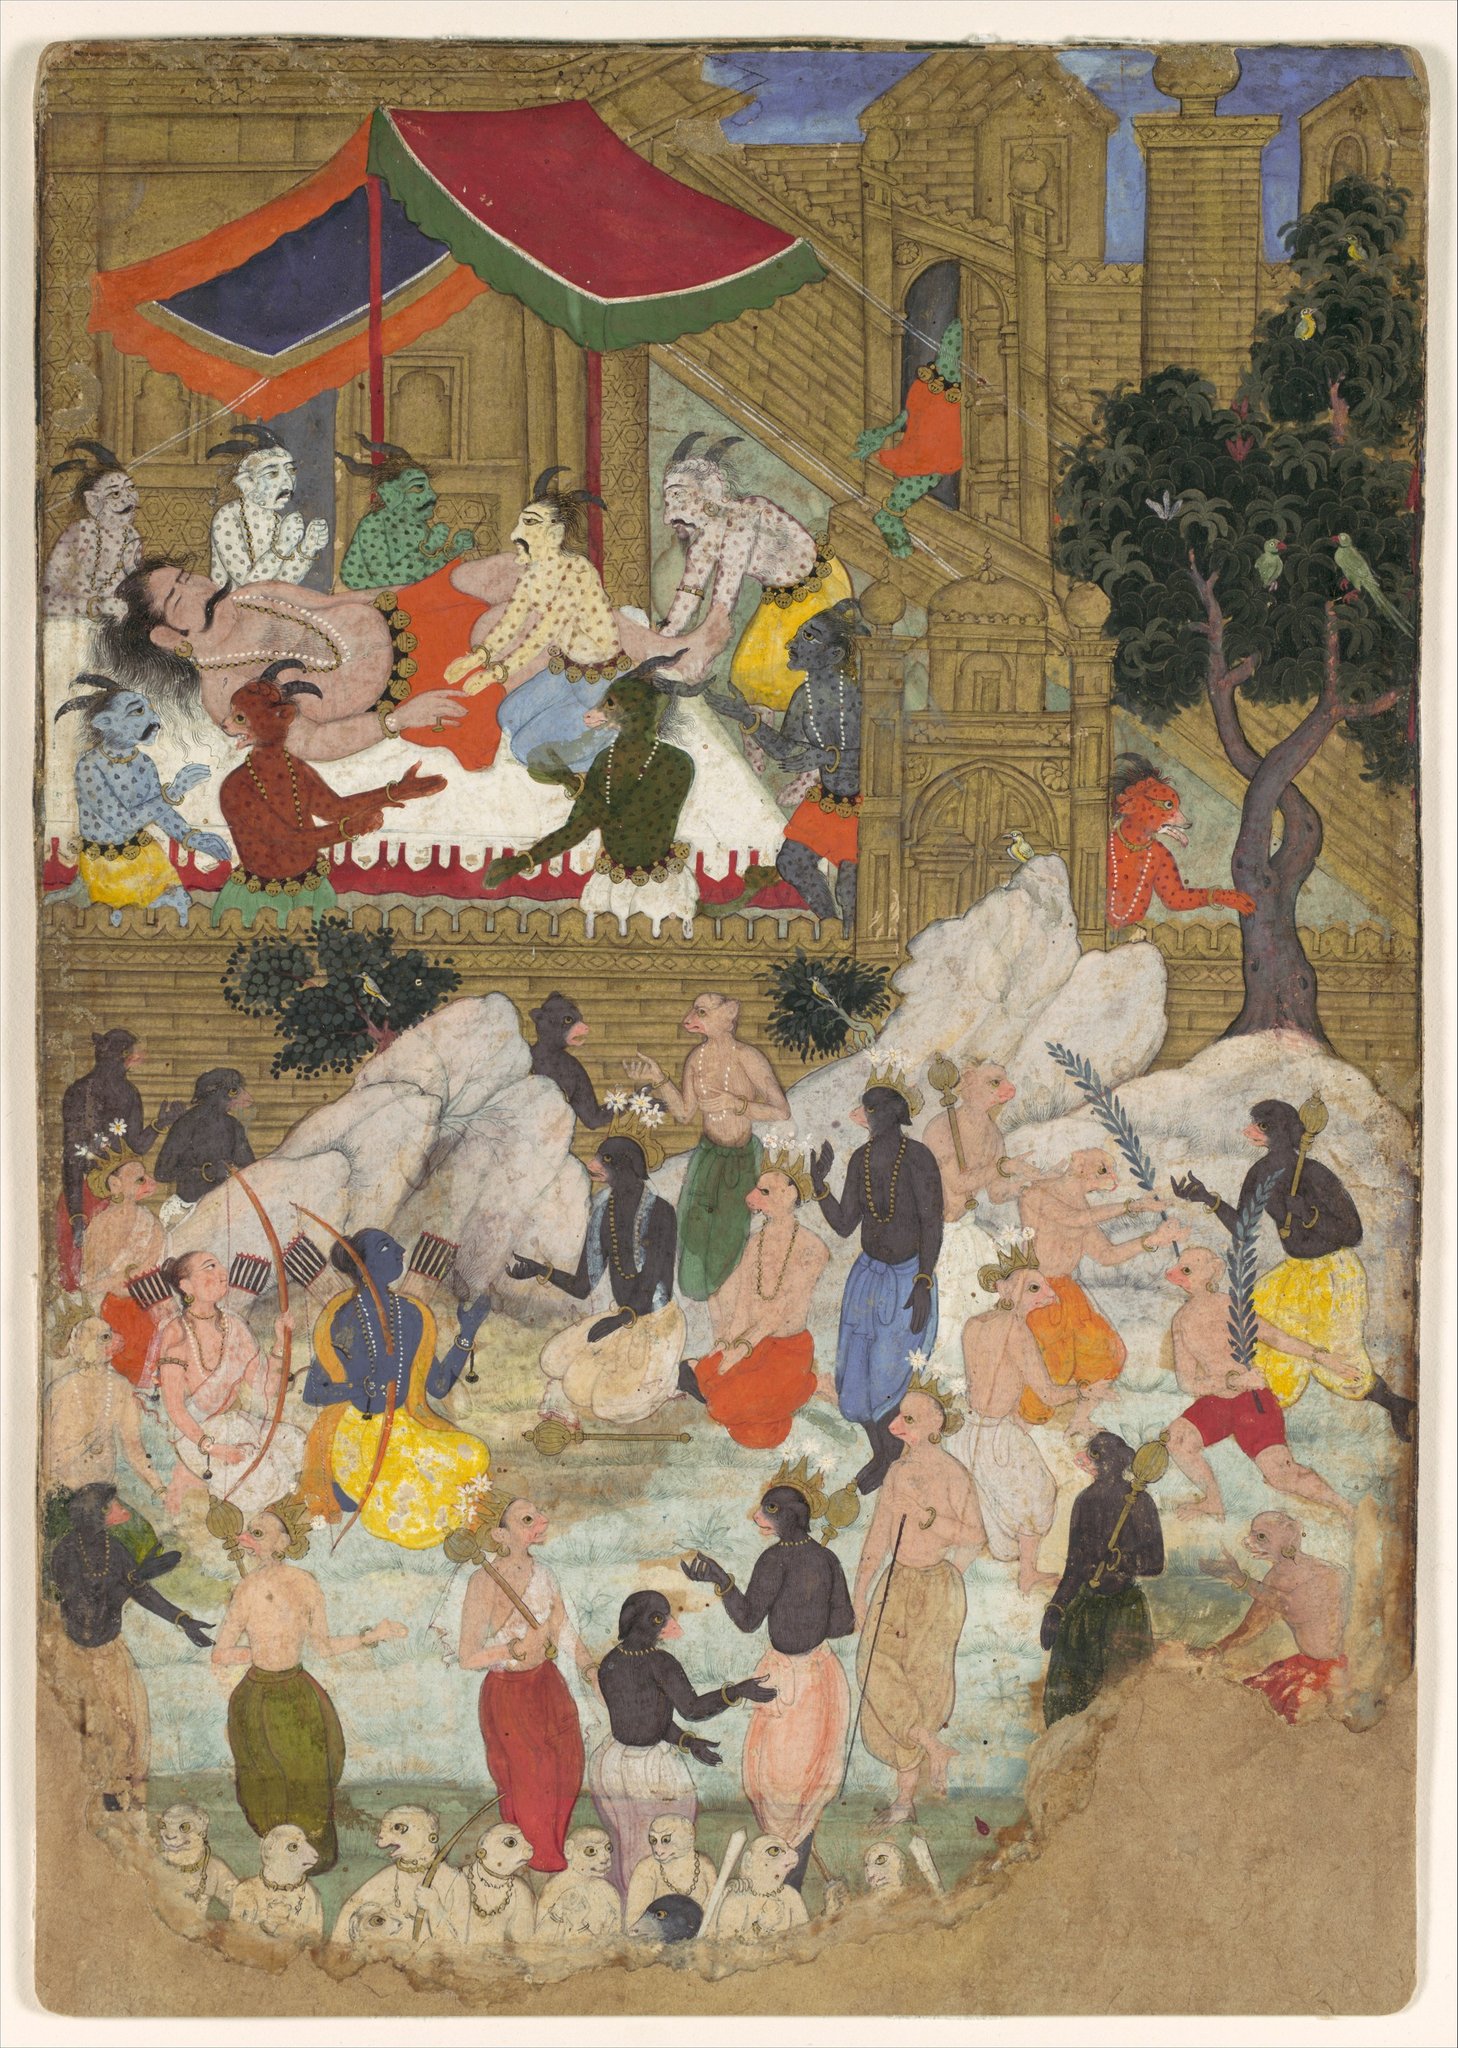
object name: folio from an illustrated manuscript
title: "The Awakening of Kumbhakarna in the Golden City of Lanka", Folio from a Ramayana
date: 1605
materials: gold, paper, watercolor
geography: india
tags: sleeping,men,demons